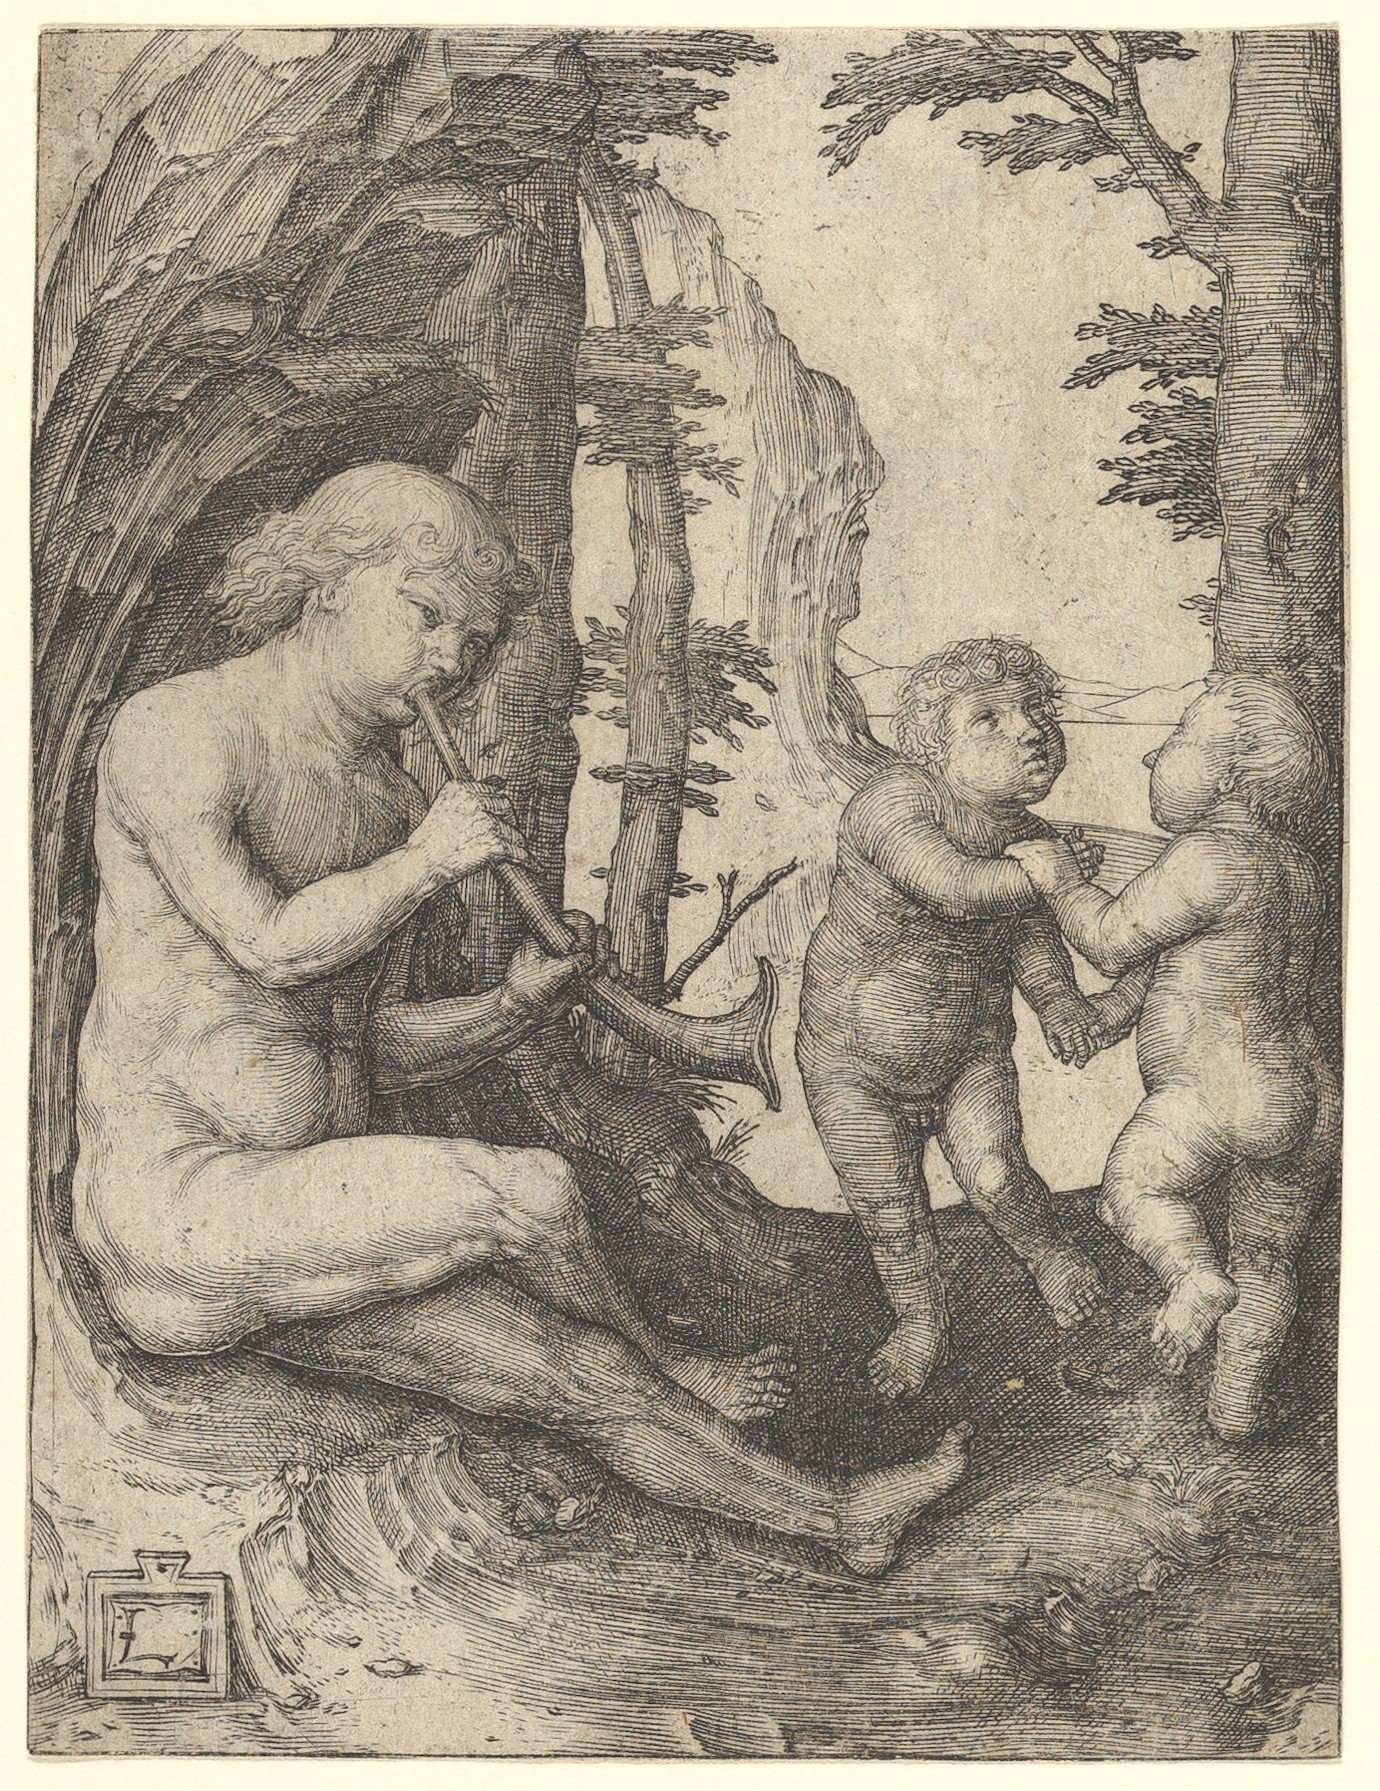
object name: print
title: Boy with a Trumpet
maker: lucas van leyden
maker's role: artist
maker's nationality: netherlandish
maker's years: 1494-1533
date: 1507-1520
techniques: engraving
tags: boys,trumpets